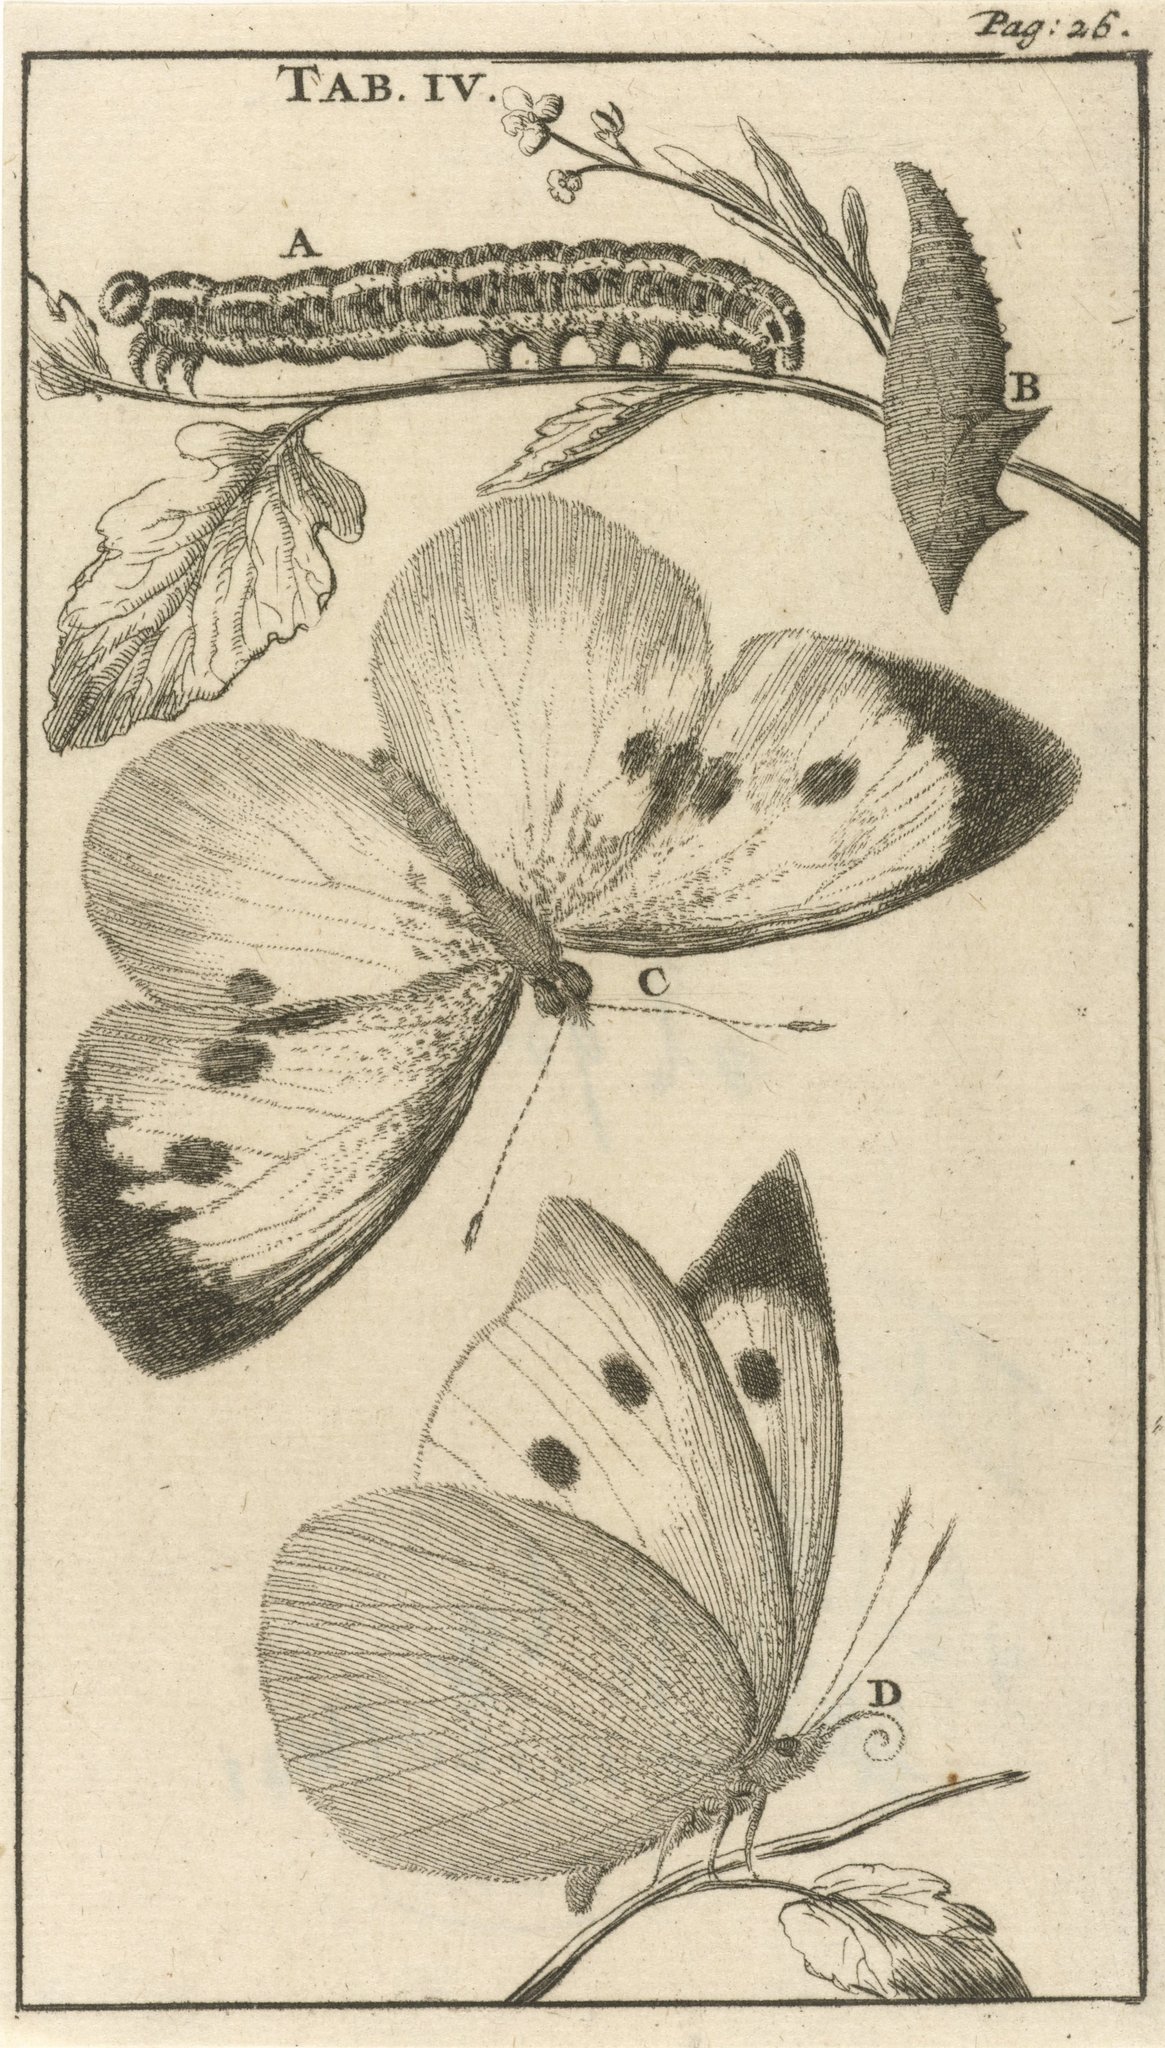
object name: book illustration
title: Rupsen, poppen en vlinders IV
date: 1680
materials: paper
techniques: etching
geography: amsterdam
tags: insects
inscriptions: collector's mark: Lugt 2228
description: Illustratie opgenomen in: Blankaart, Steven. Schou-burg der rupsen, wormen, ma'den, en vliegende dierkens daar uit voortkomende. Amsterdam: Jan Claesz ten Hoorn, 1680.